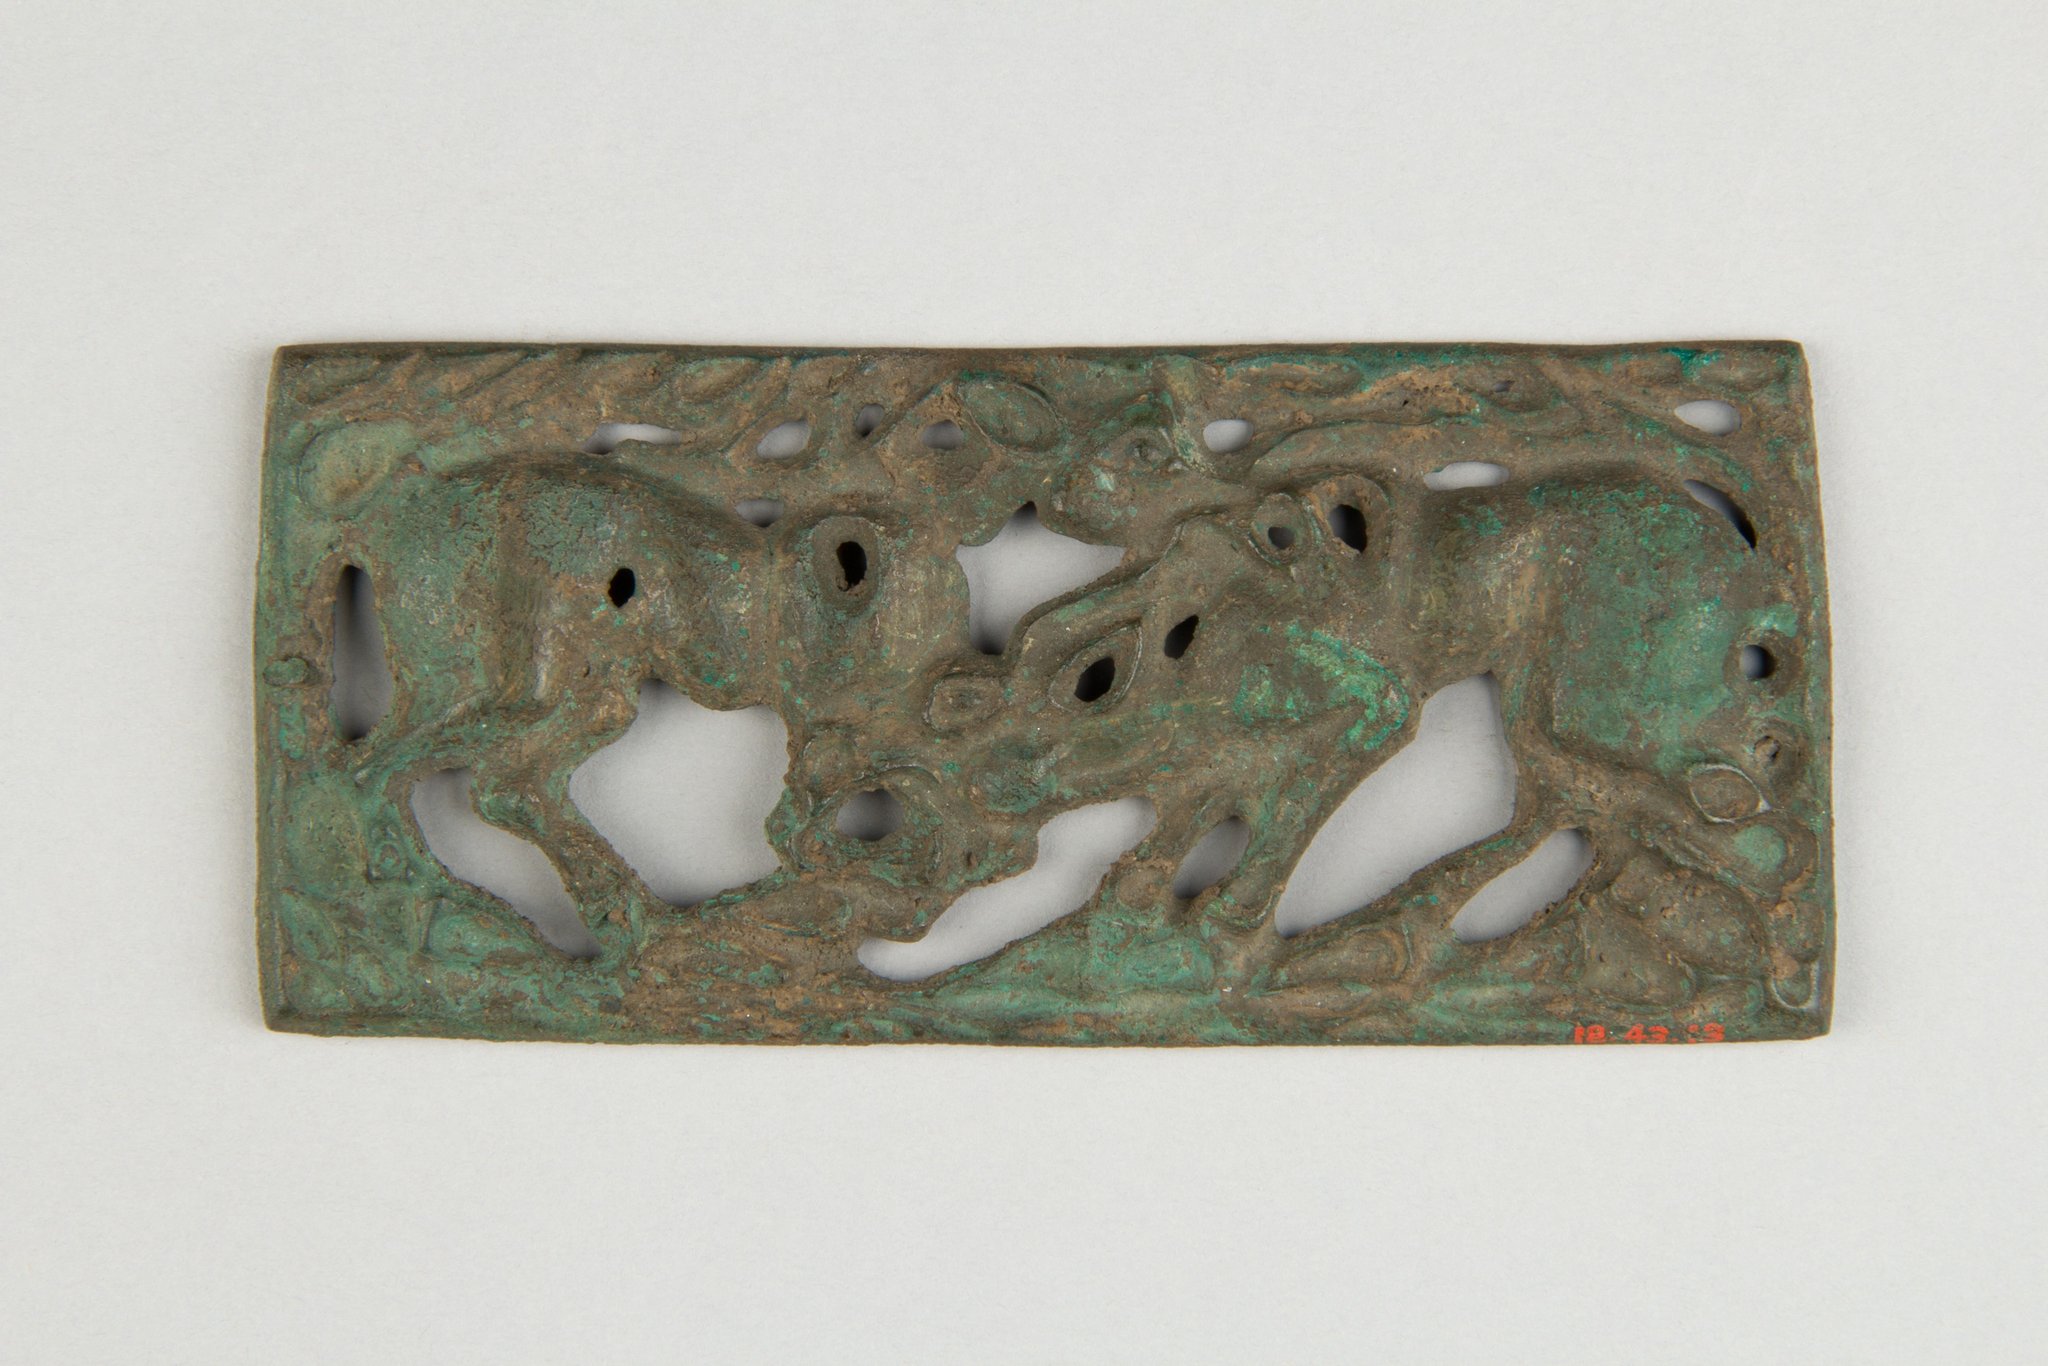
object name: plaque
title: Openwork Plaque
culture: chinese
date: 206 BCE-220 CE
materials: bronze